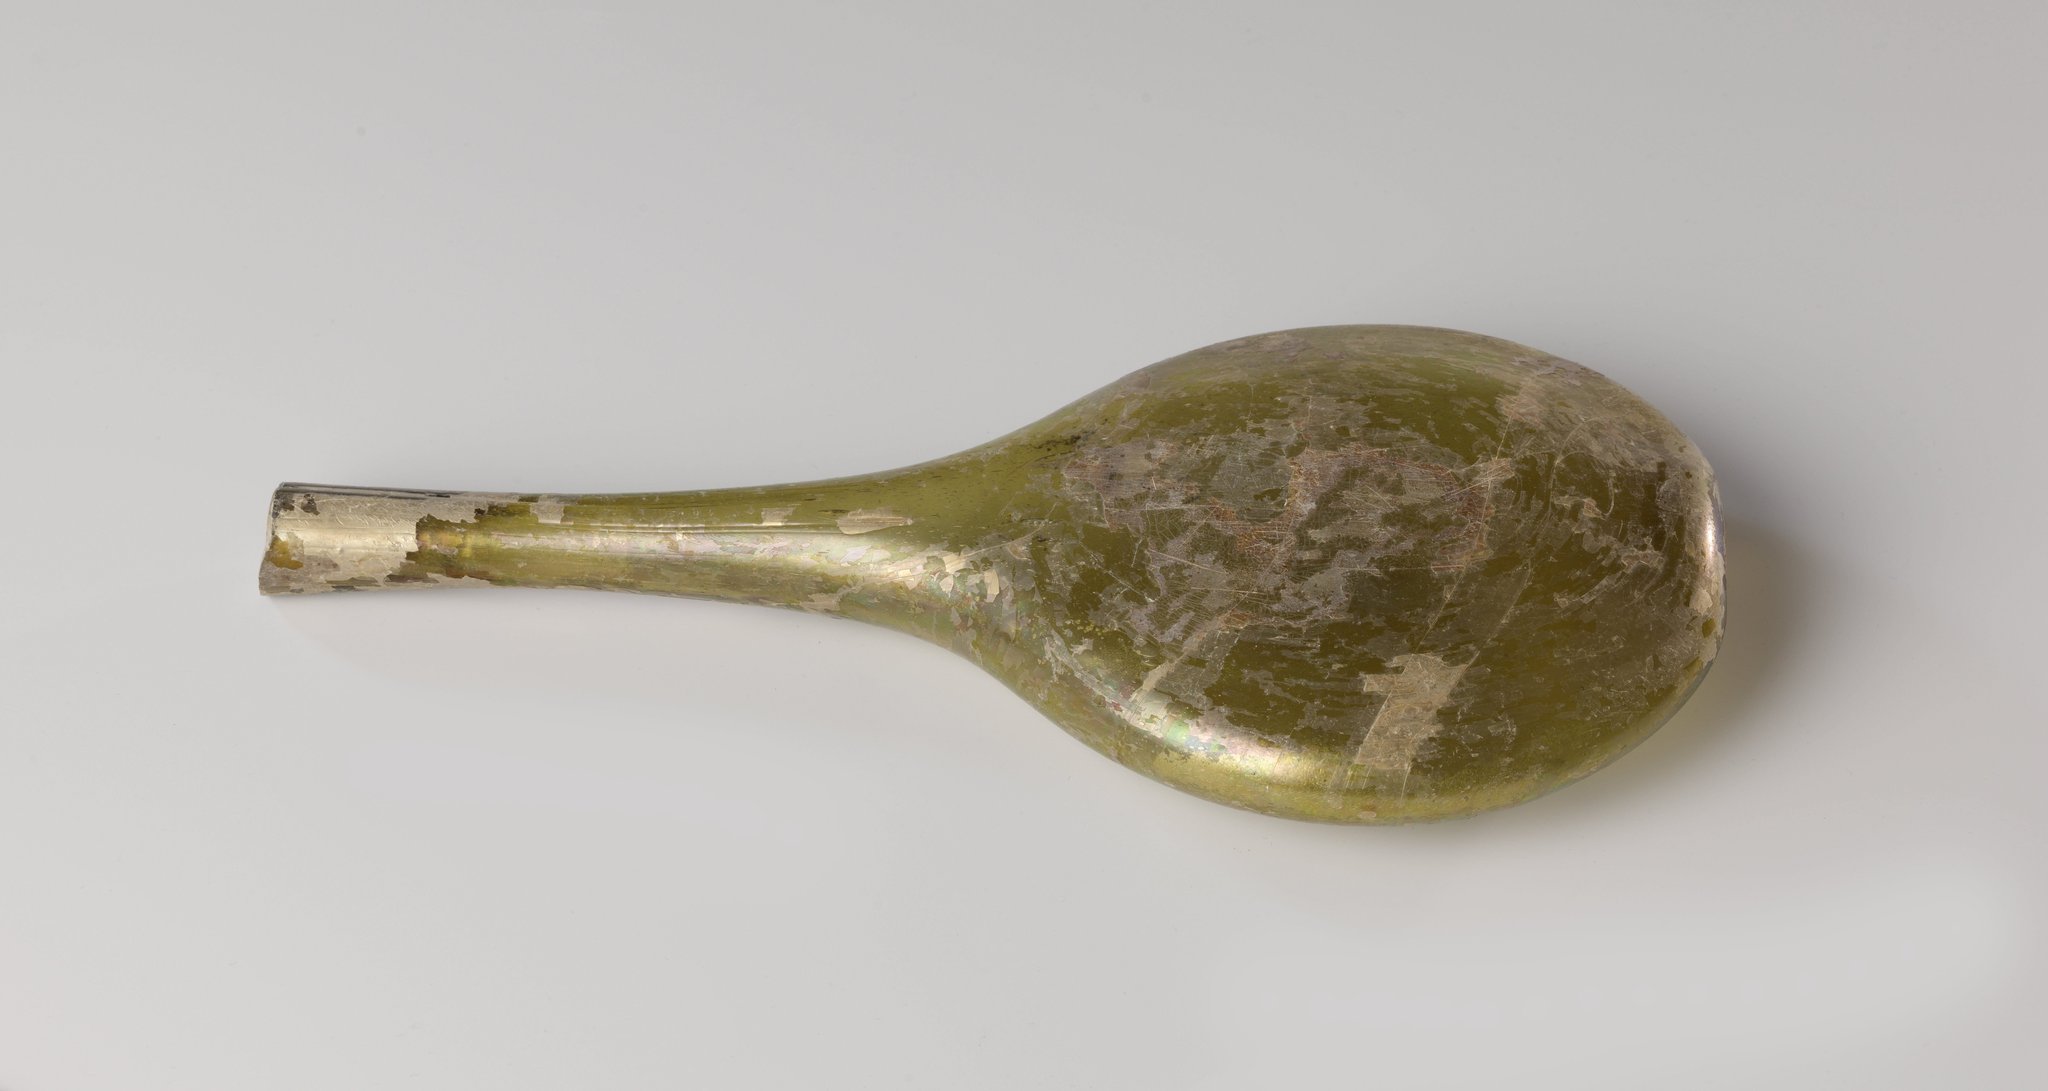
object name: spawaterfles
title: Spawaterfles met afgeplat, bolvormig lichaam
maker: Anonymous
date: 1600-1800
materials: glass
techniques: glassblowing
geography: southern netherlands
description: Licht ingestoken ziel, zijdelings afgeplat rond lichaam, overgaand in een hoge hals.